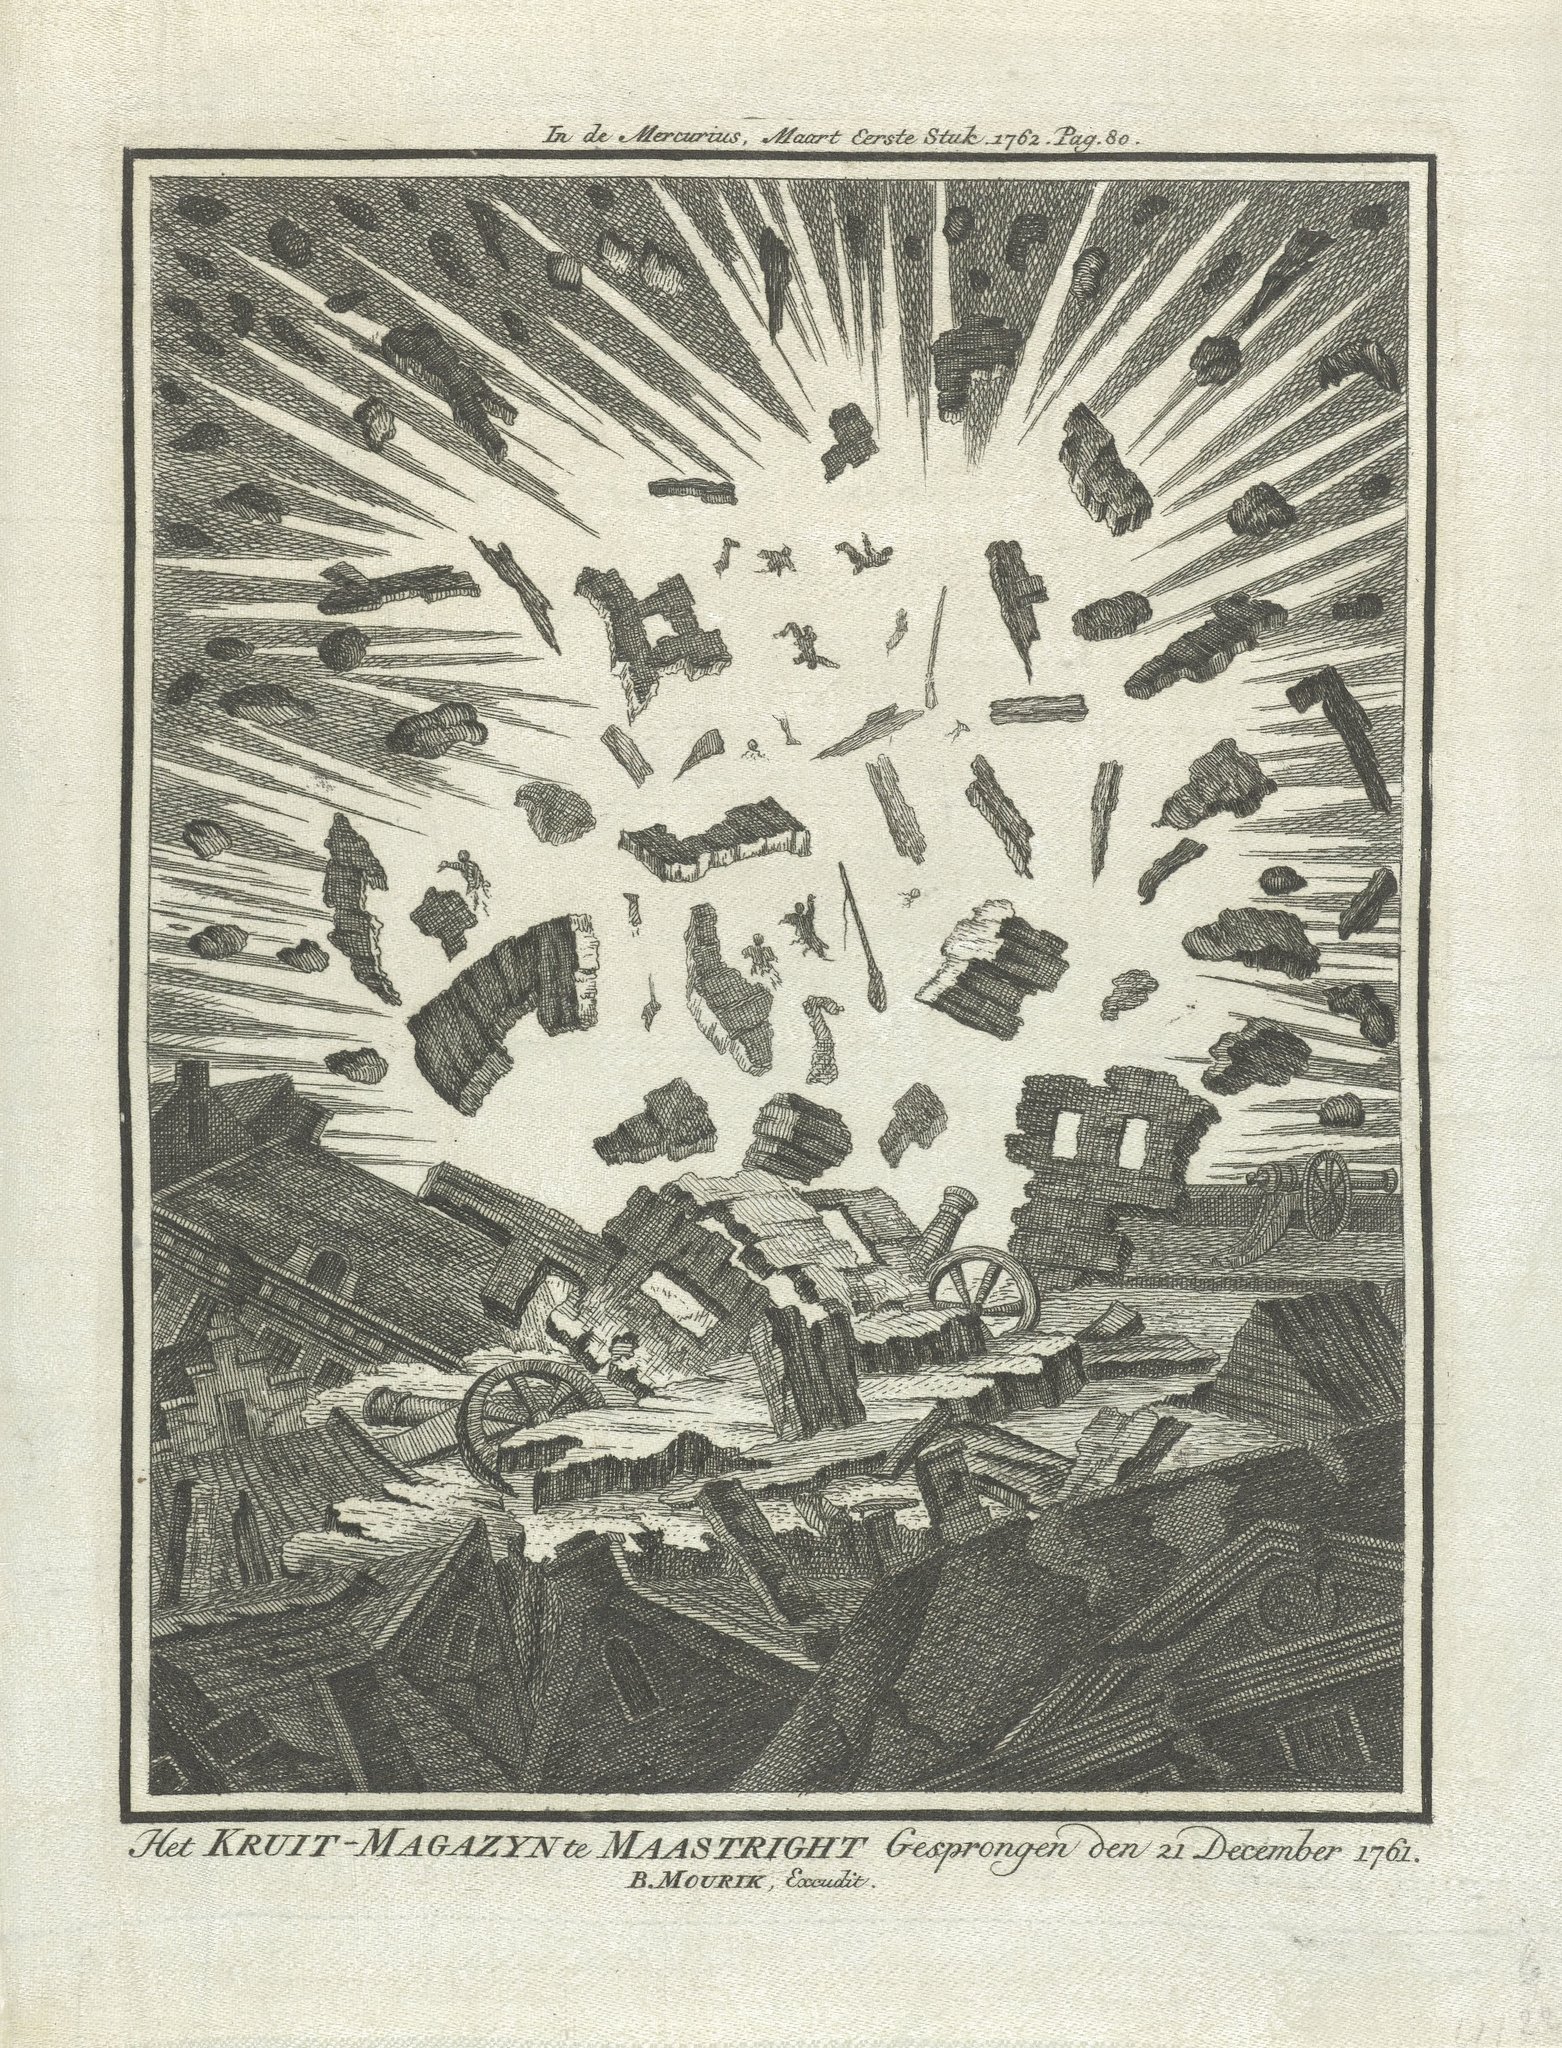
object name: print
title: Het Kruit-Magazyn te Maastricht Gesprongen den 21 December 1761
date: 1762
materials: textile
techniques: etching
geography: northern netherlands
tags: gunpowder disaster, maastricht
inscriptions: collector's mark: Lugt 2228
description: De ontploffing van het kruitmagazijn te Maastricht op 21 december 1761. Door de explosie worden brokstukken van het gebouw en mensen de lucht in geblazen. Gemerkt bovenaan: In de Mercurius, Maart Eerste Stuk. 1762. Pag. 80.